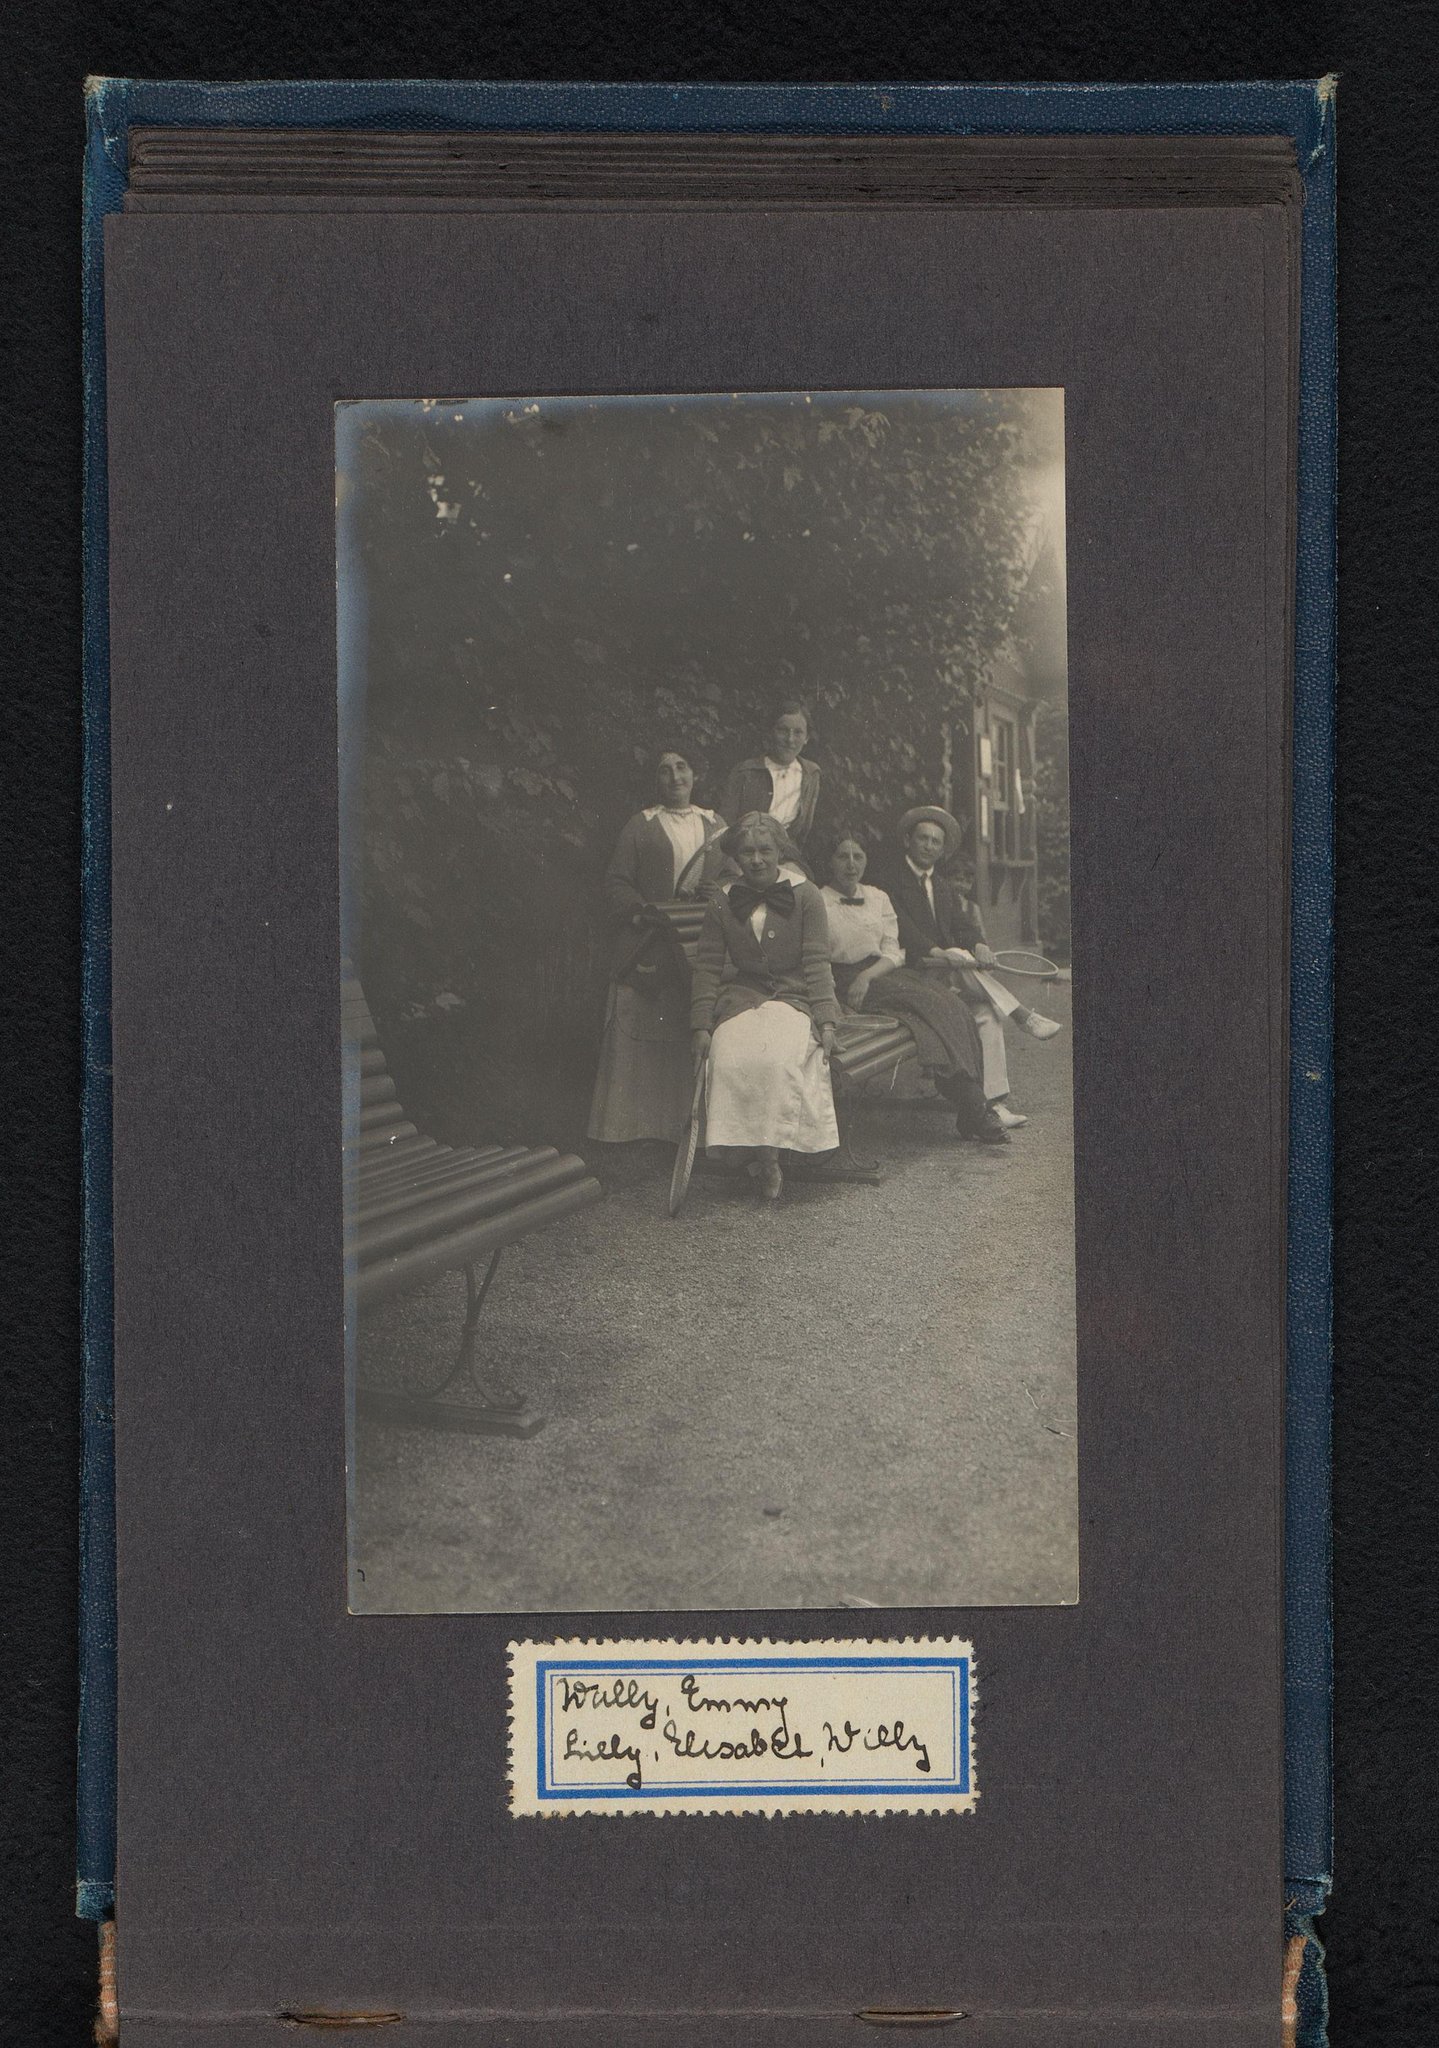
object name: photograph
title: Op de tennisbaan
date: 1913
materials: paper, photographic support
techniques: gelatin silver print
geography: switzerland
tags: else wachenheimer-moos, tennis, lawn-tennis, switzerland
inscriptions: inscription: ‘Wully, Emmy, Lilly, Elisabeth, Willy’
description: Albumblad met een foto van Wully, Emmy, Lilly, Elisabeth en Willy, met tennisrackets, naast de tennisbaan, bij Hotel Waldhaus Vulpera, Zwitserland. Onderdeel van het fotoalbum van Else Wachenheimer-Moos en haar broers Arthur en Willy Moos en anderen in de periode 1913-1918.